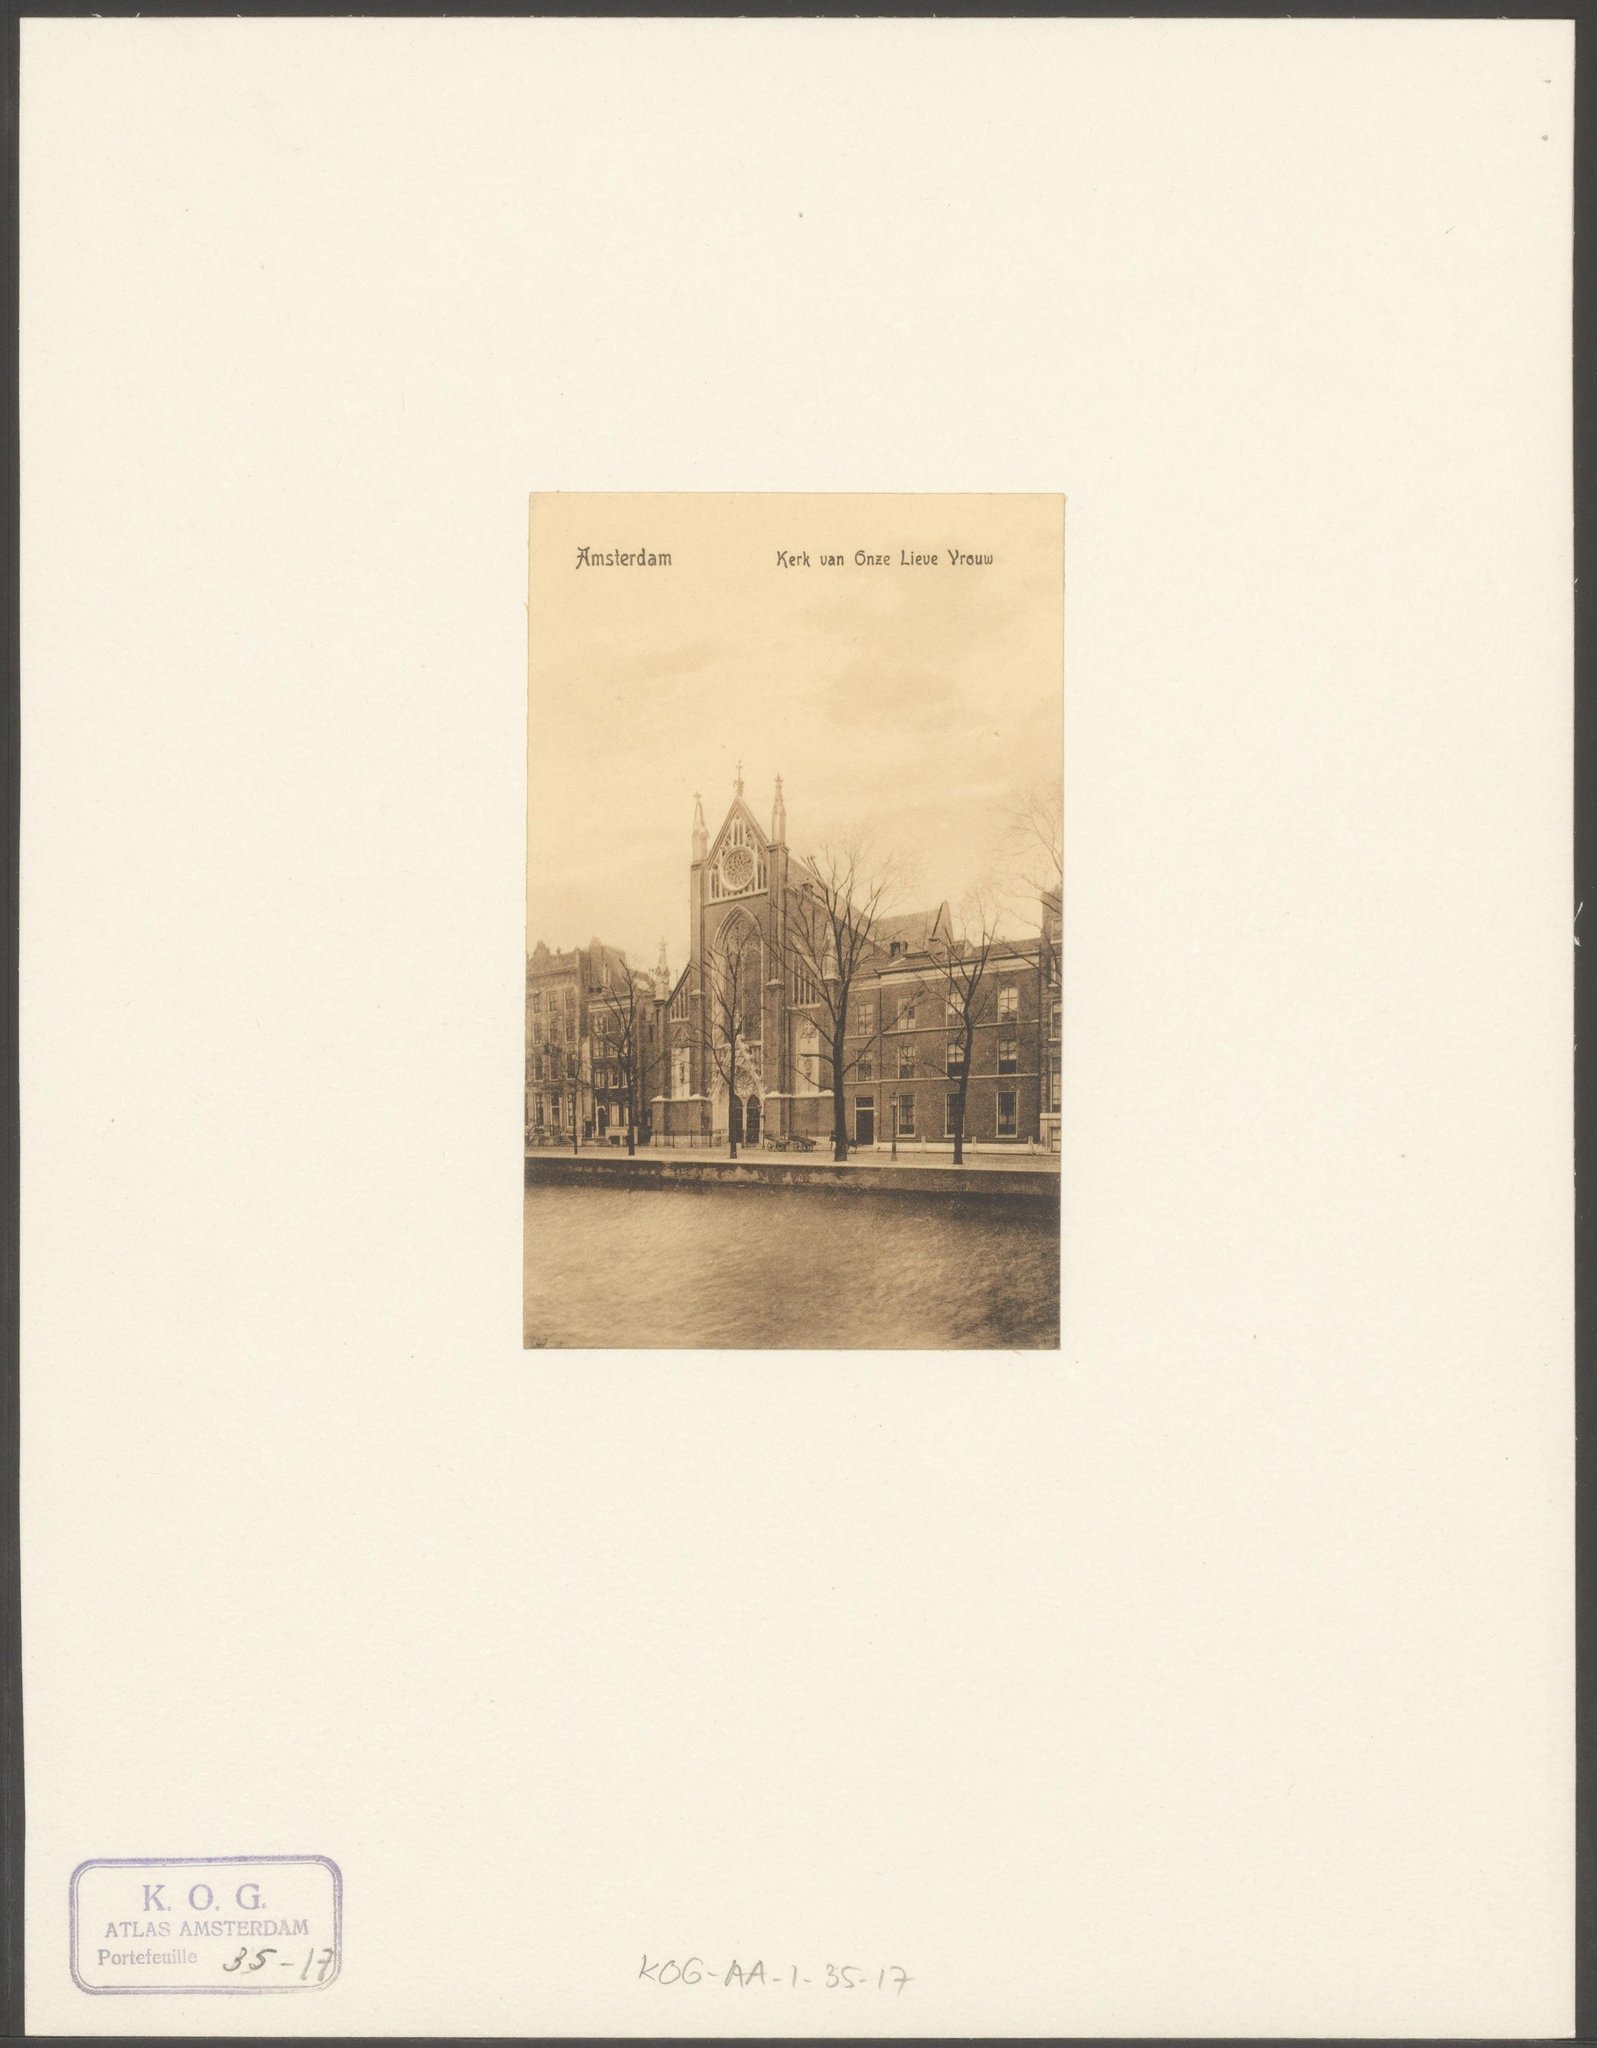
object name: photomechanical print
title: Amsterdam Kerk van Onze Lieve Vrouw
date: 1910-1912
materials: cardboard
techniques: photograph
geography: amsterdam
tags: regular clerics, e.g. jesuits, redemptorists, parts of church exterior and annexes: façade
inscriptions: collector's mark: ‘35-17’ Lugt 1641b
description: Onderwerpsrubriek binnen de Atlas Amsterdam: R.K. Gemeenten: Sint Nicolaaskerk t/m Willibrordus (Rustenburgerstraat).